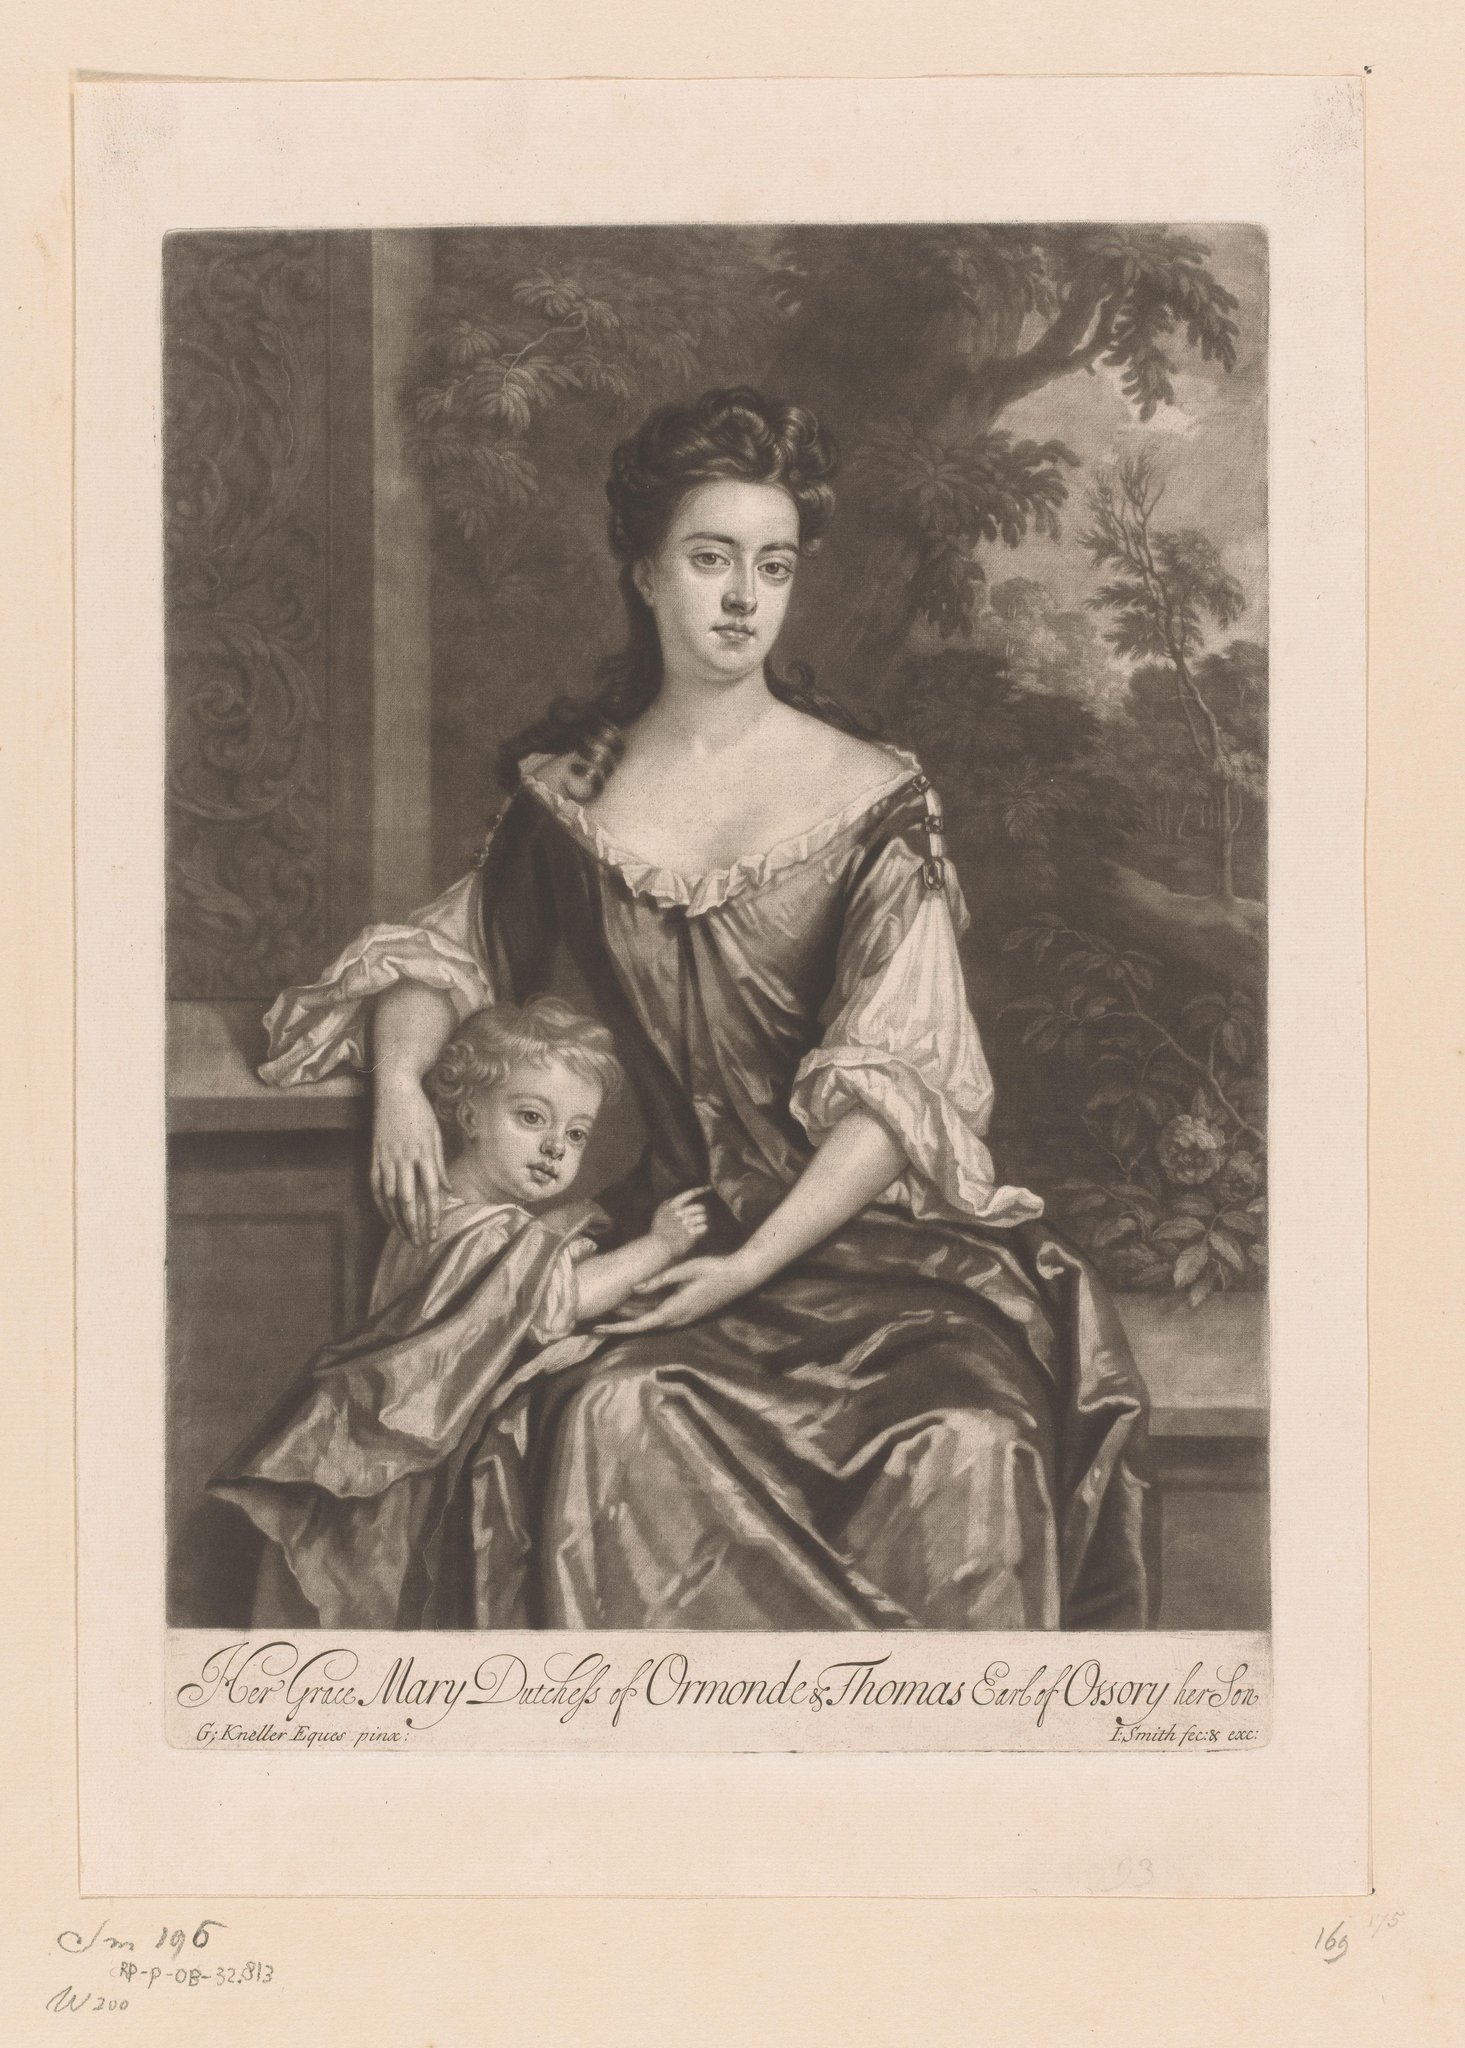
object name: print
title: Her Grace Mary Dutchess of Ormondes & Thomas Earl of Ossory her Son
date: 1687-1742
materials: paper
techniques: mezzotint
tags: mother and son(s) (family group), boy (child between toddler and youth), historical persons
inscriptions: collector's mark: Lugt 240